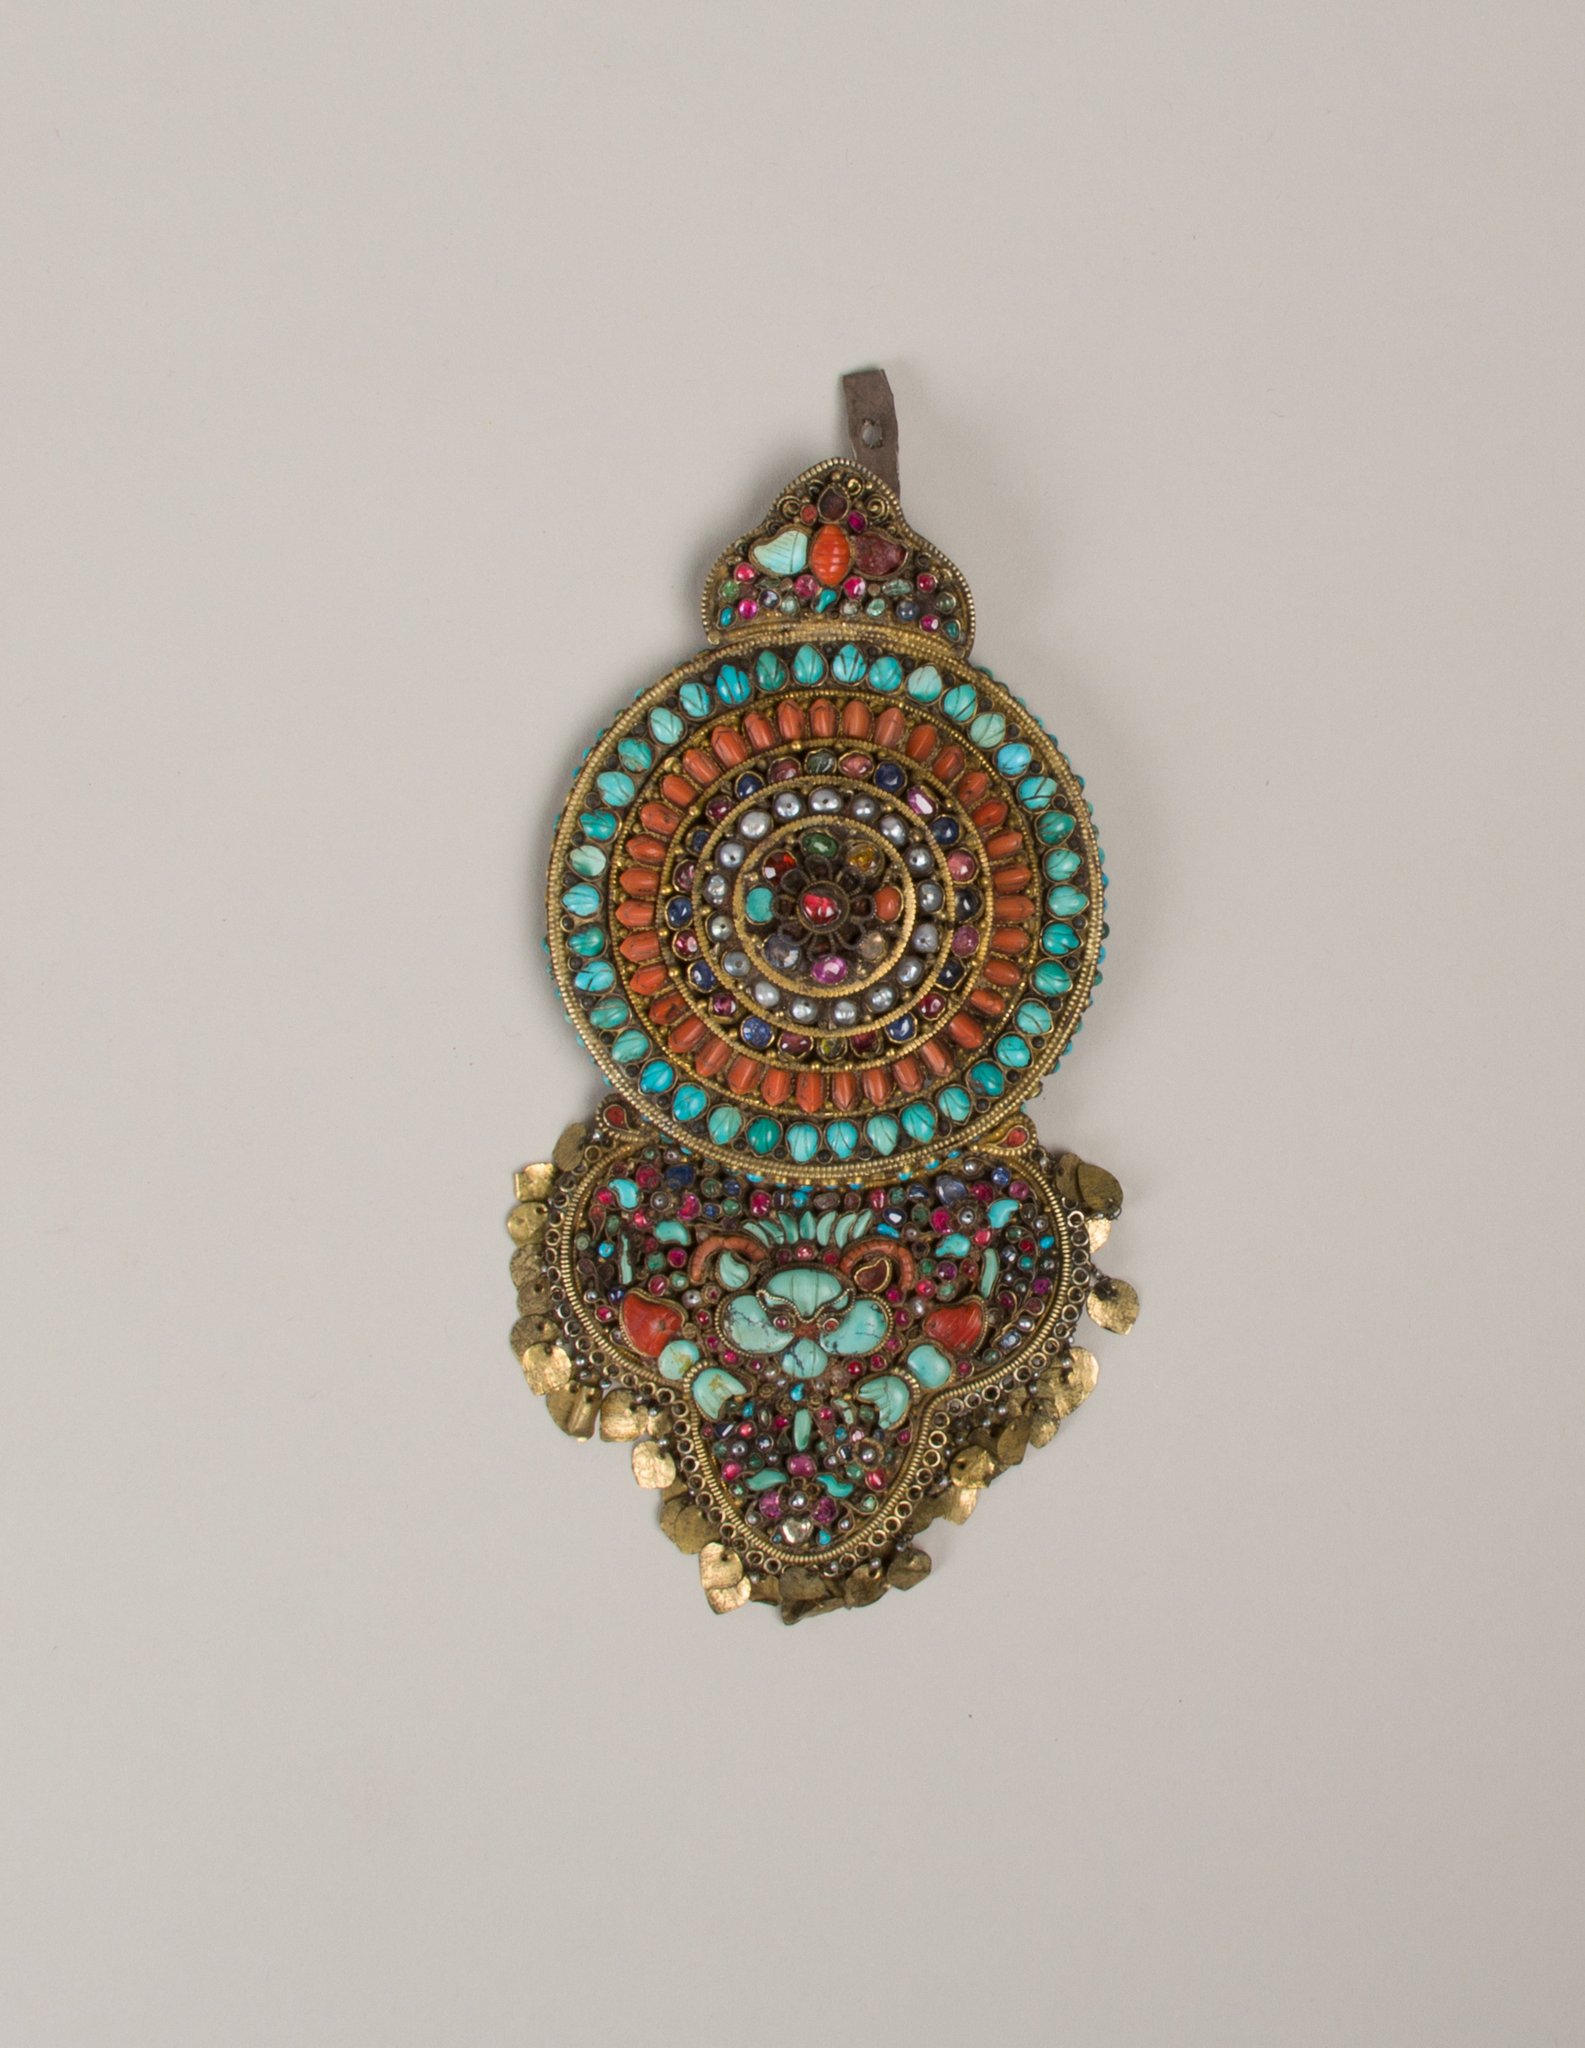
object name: earring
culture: tibetan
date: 1601-1900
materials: silver gilt, stone